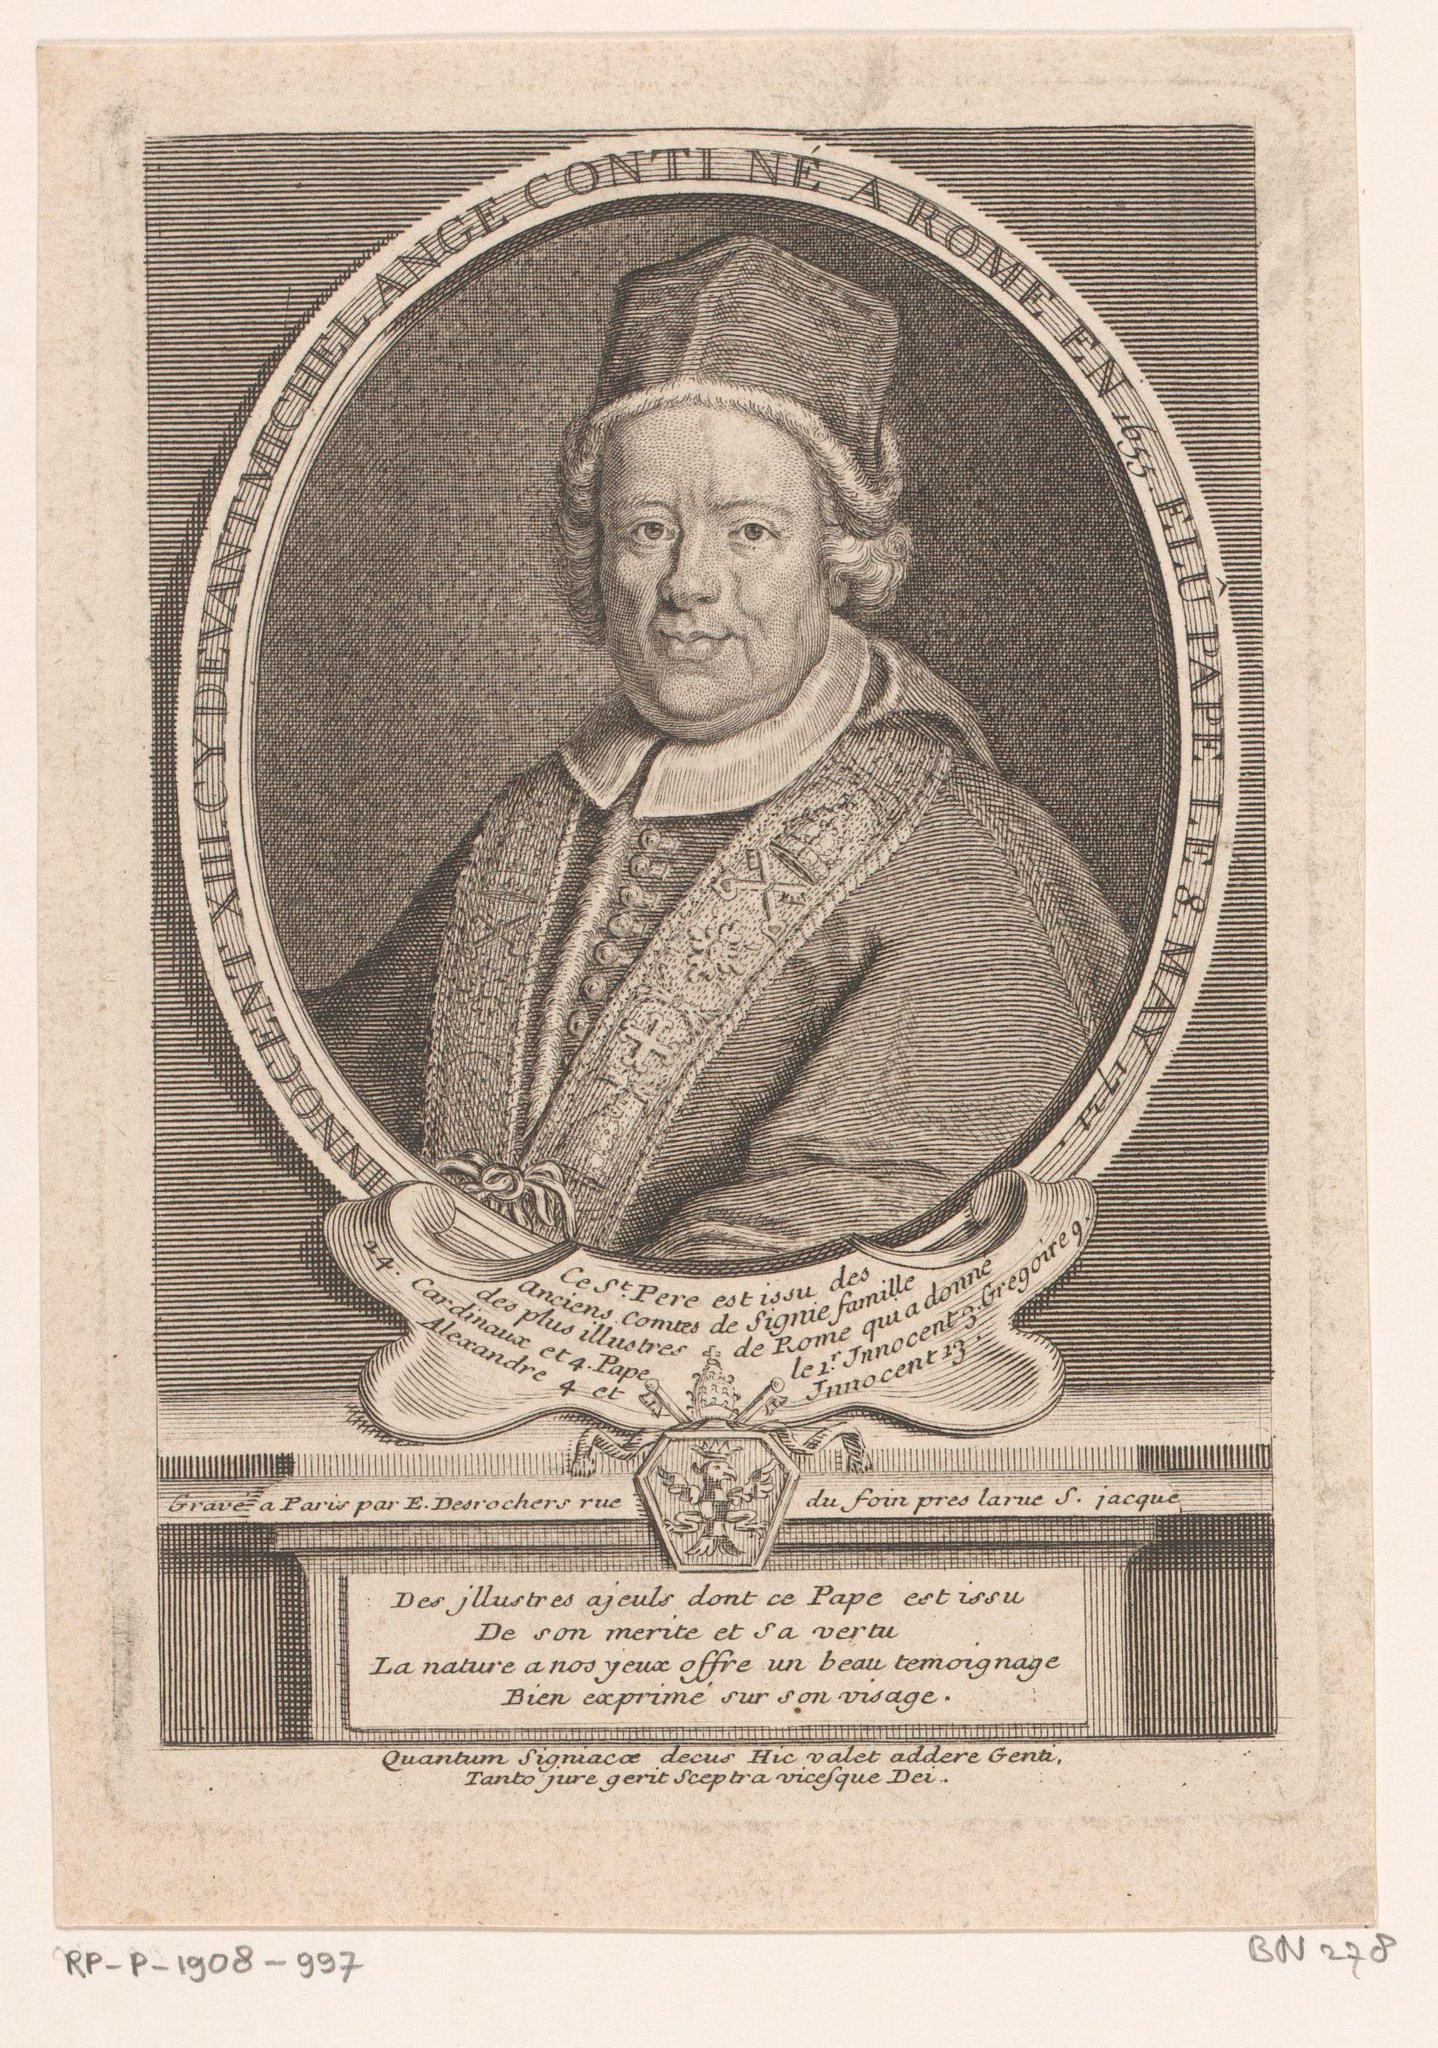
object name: print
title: Recueil de portraits (...)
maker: étienne desrochers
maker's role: print maker, publisher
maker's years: 1668-1741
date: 1726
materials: paper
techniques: engraving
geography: paris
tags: historical persons, pope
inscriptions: collector's mark: Lugt 2228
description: Behoort waarschijnlijk tot een serie portretten, grotendeels door Etienne Desrochers, getiteld: 'Recueil de portraits de personnes qui se sont distinguées tant dans les Armes que dans Belles-Lettres et les Arts, comme aussi la famille royale de France et autres cours étrangères'. De serie werd initieel uitgegeven door Desrochers en aangekondigd in 'Mercure' in mei 1726, p. 985. Echter was Desrochers reeds enkele jaren eerder begonnen met het uitgeven van de serie. Na de dood van Desrochers werd de serie voortgezet door Gilles Edme Petit. Een latere staat werd uitgegeven door Jean François Daumont in Parijs.